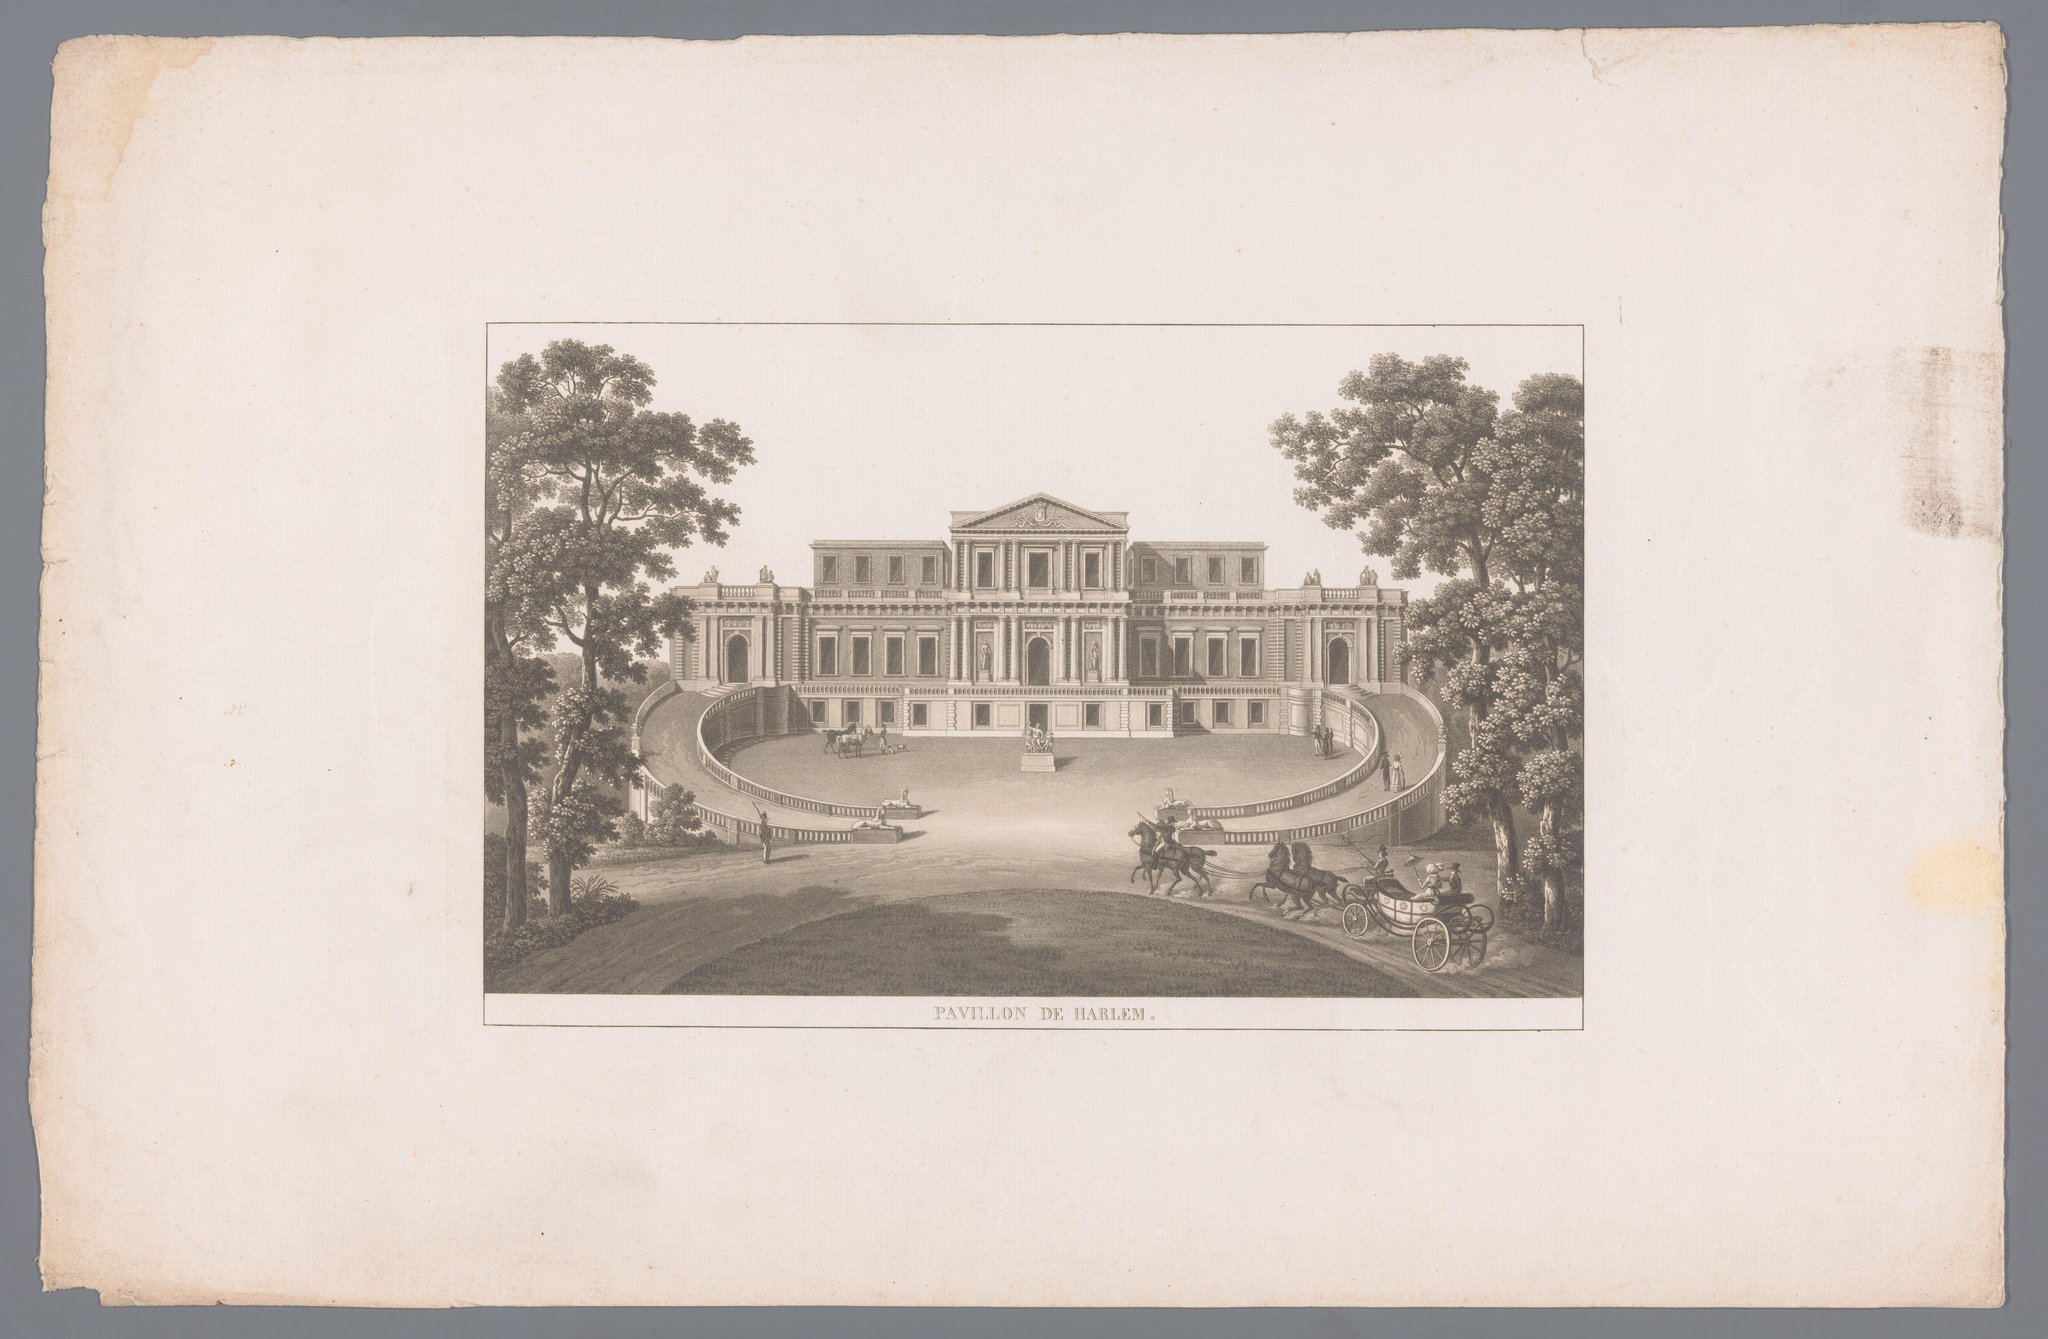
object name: print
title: Pavillon de Harlem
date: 1825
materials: paper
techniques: aquatint, etching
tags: rural housing, e.g. country-house, villa, cottage, passenger carriage, haarlem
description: Prent uit: Verzameling der Merkwaardigste gebouwen in het Koninkrijk der Nederlanden. Gent: P.J. Goetghebuer, 1825.